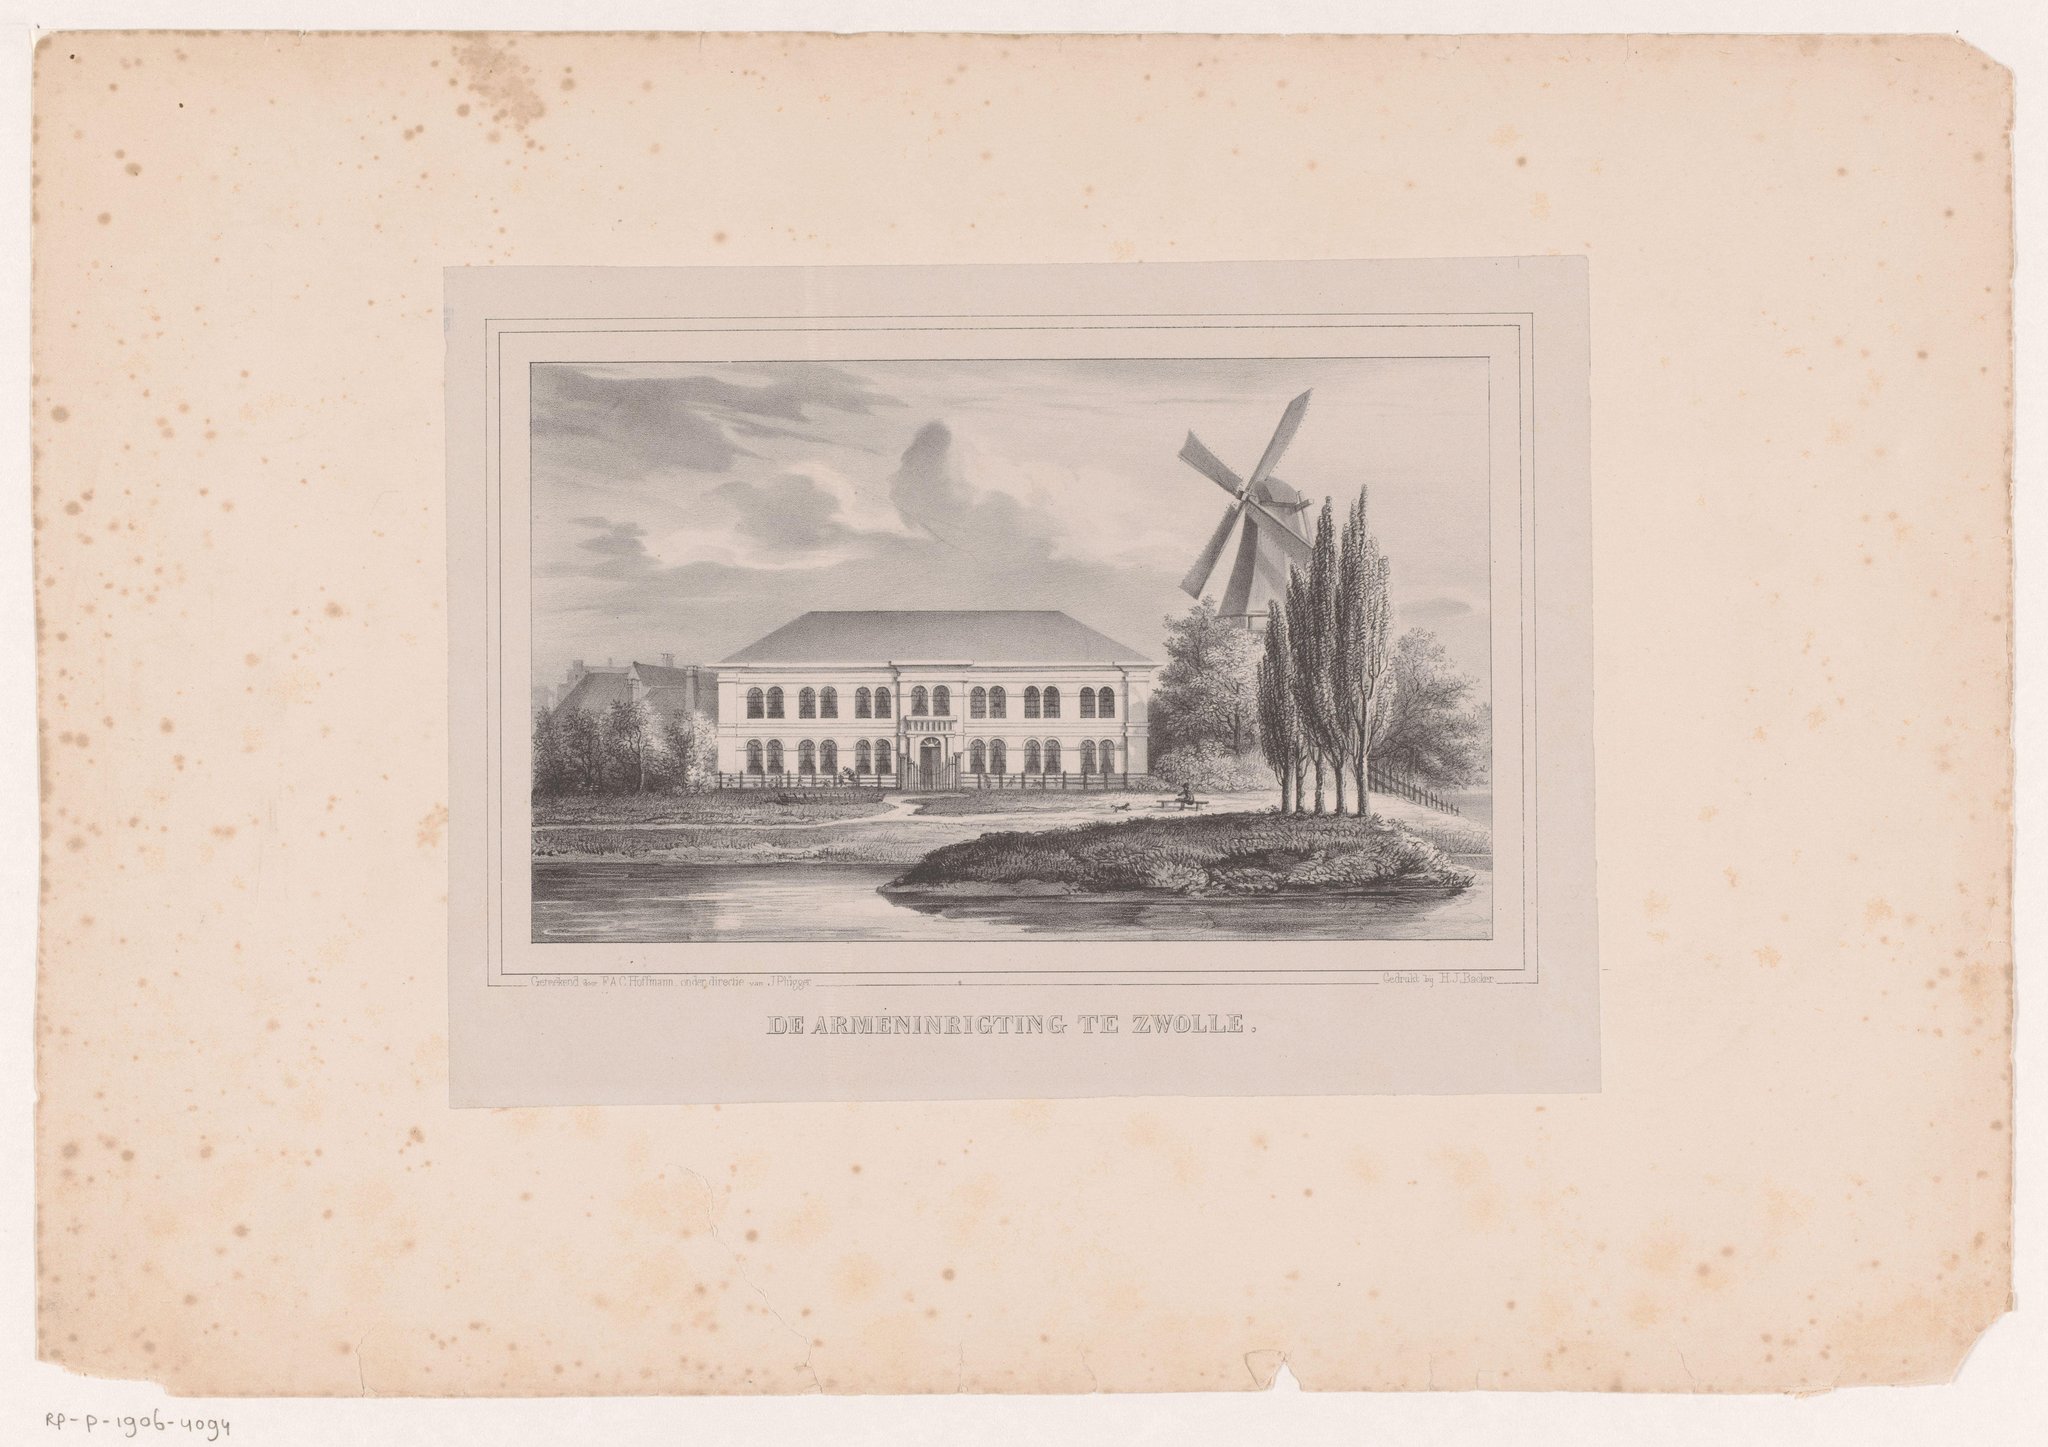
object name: print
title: De armeninrichting te Zwolle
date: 1832-1845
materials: paper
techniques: lithograph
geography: zwolle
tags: canals, waters (in city), windmill, the poor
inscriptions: collector's mark: Lugt 2228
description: Op de voorgrond ligt een eiland in de gracht. Rechts een windmolen.